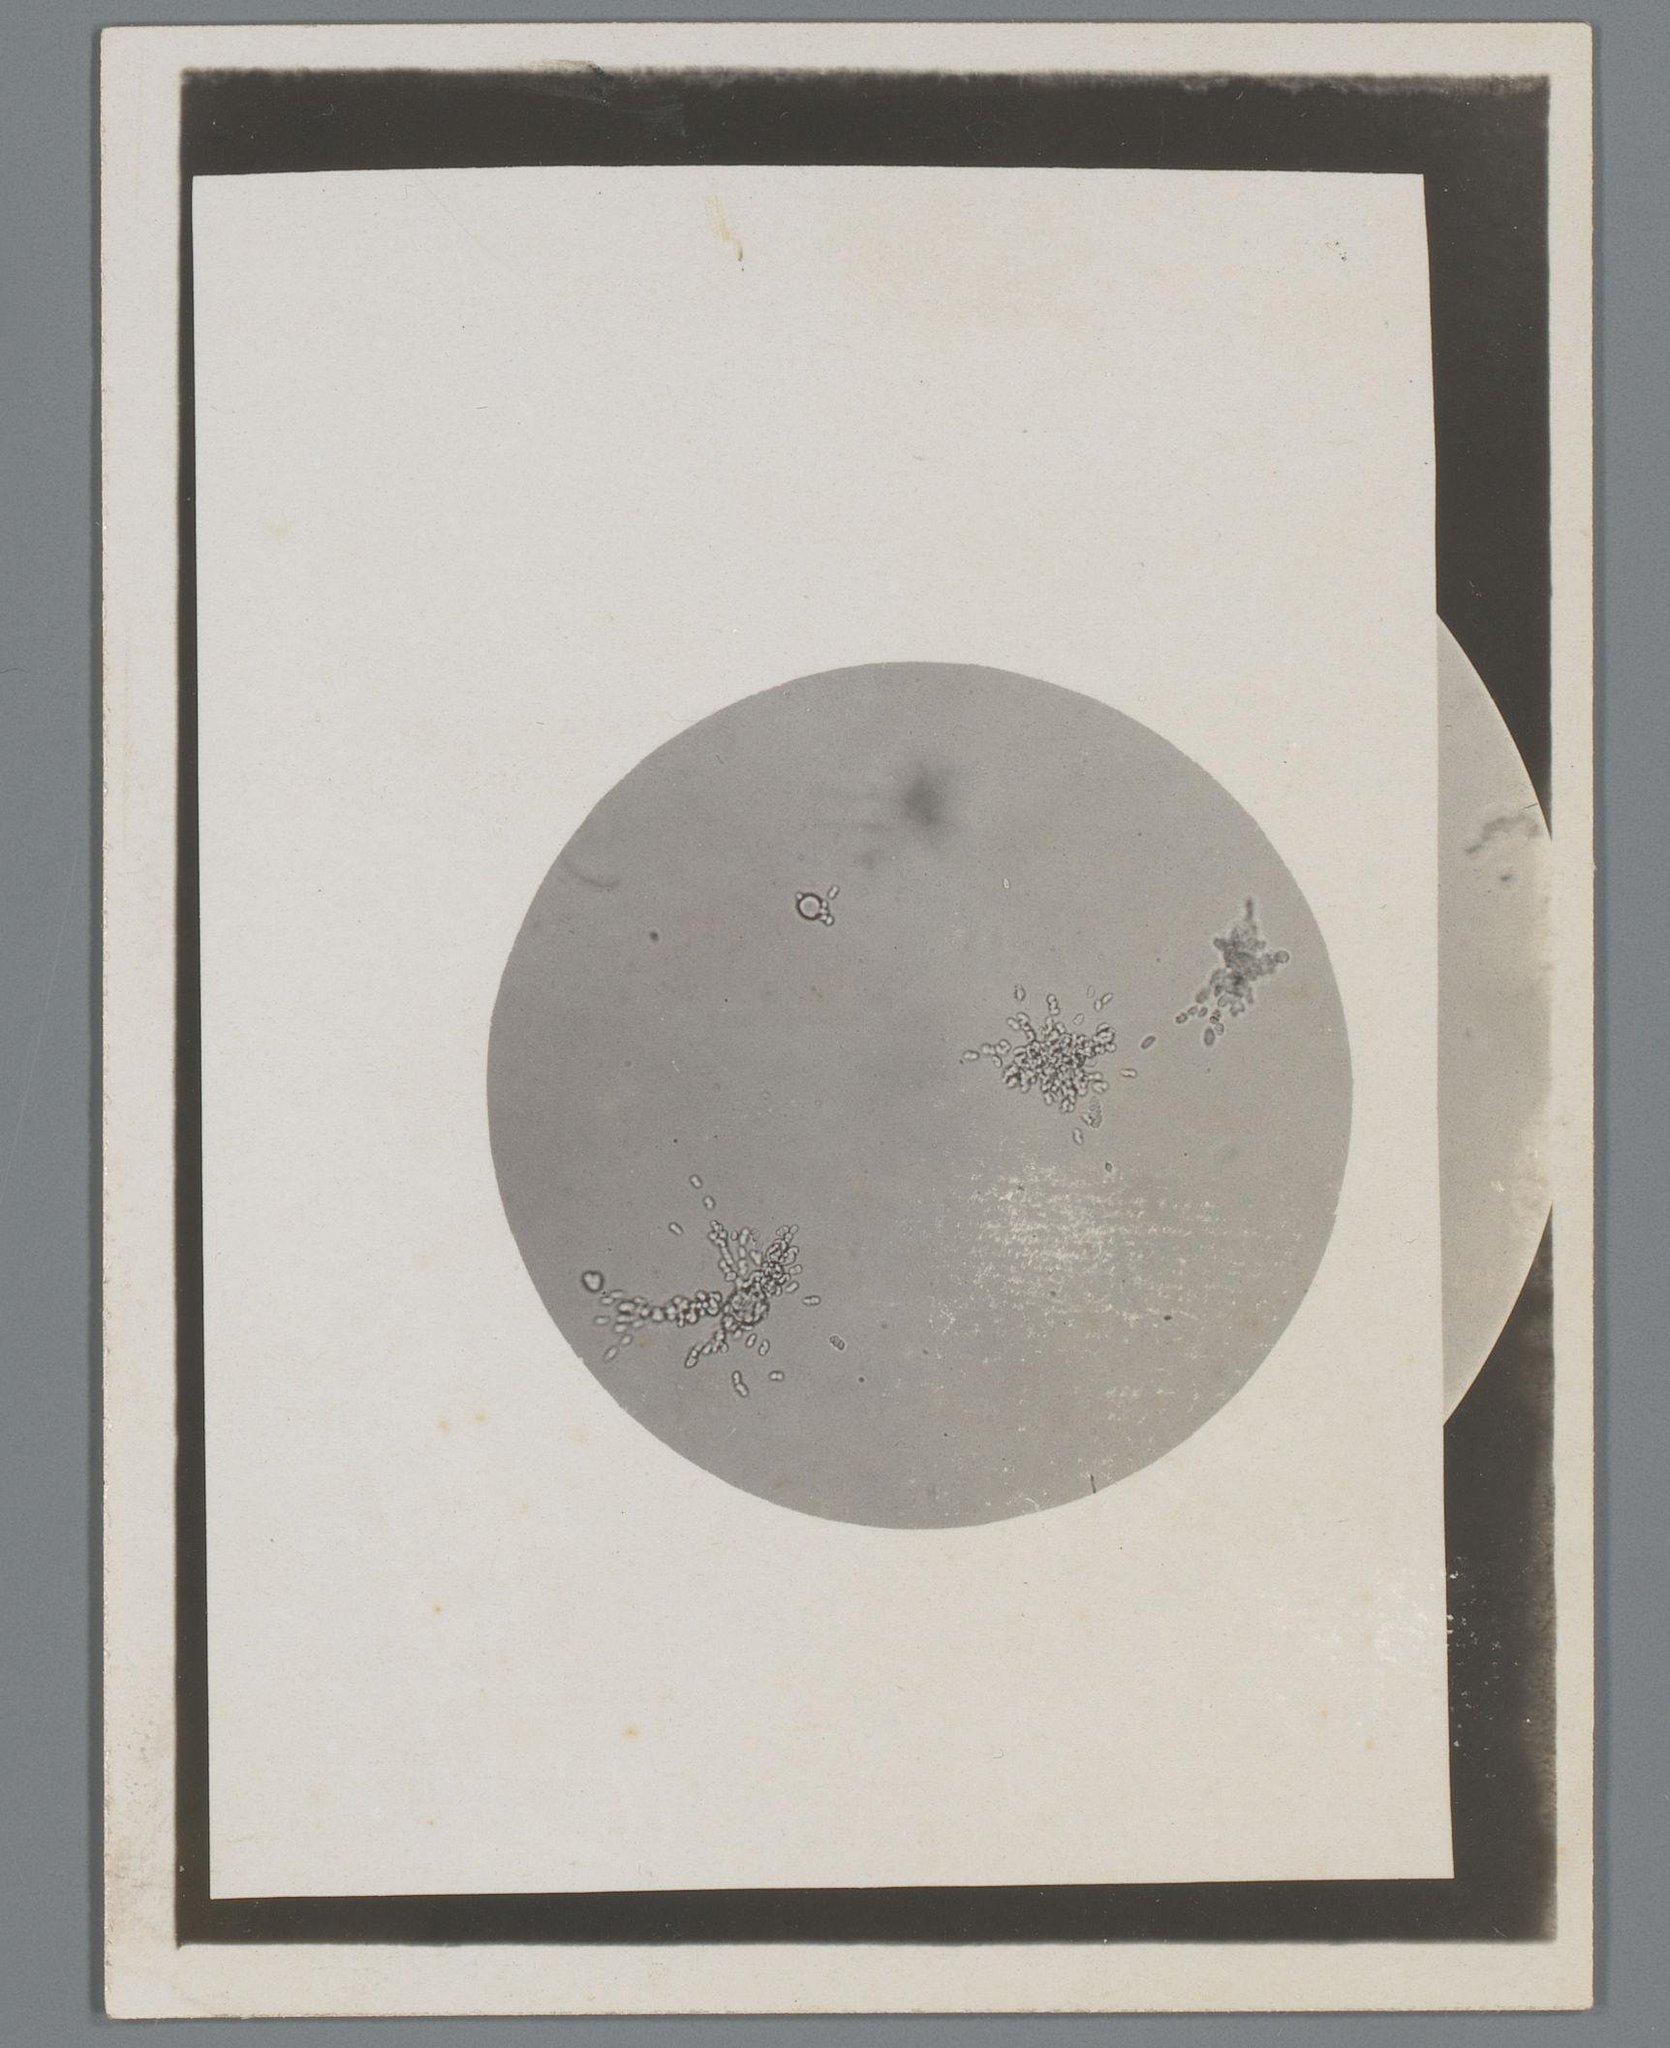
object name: photograph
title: Opname van een microscopisch preparaat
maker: Anonymous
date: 1880-1910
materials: paper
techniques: gelatin silver print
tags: unicellular animals, bacteria, bacilli